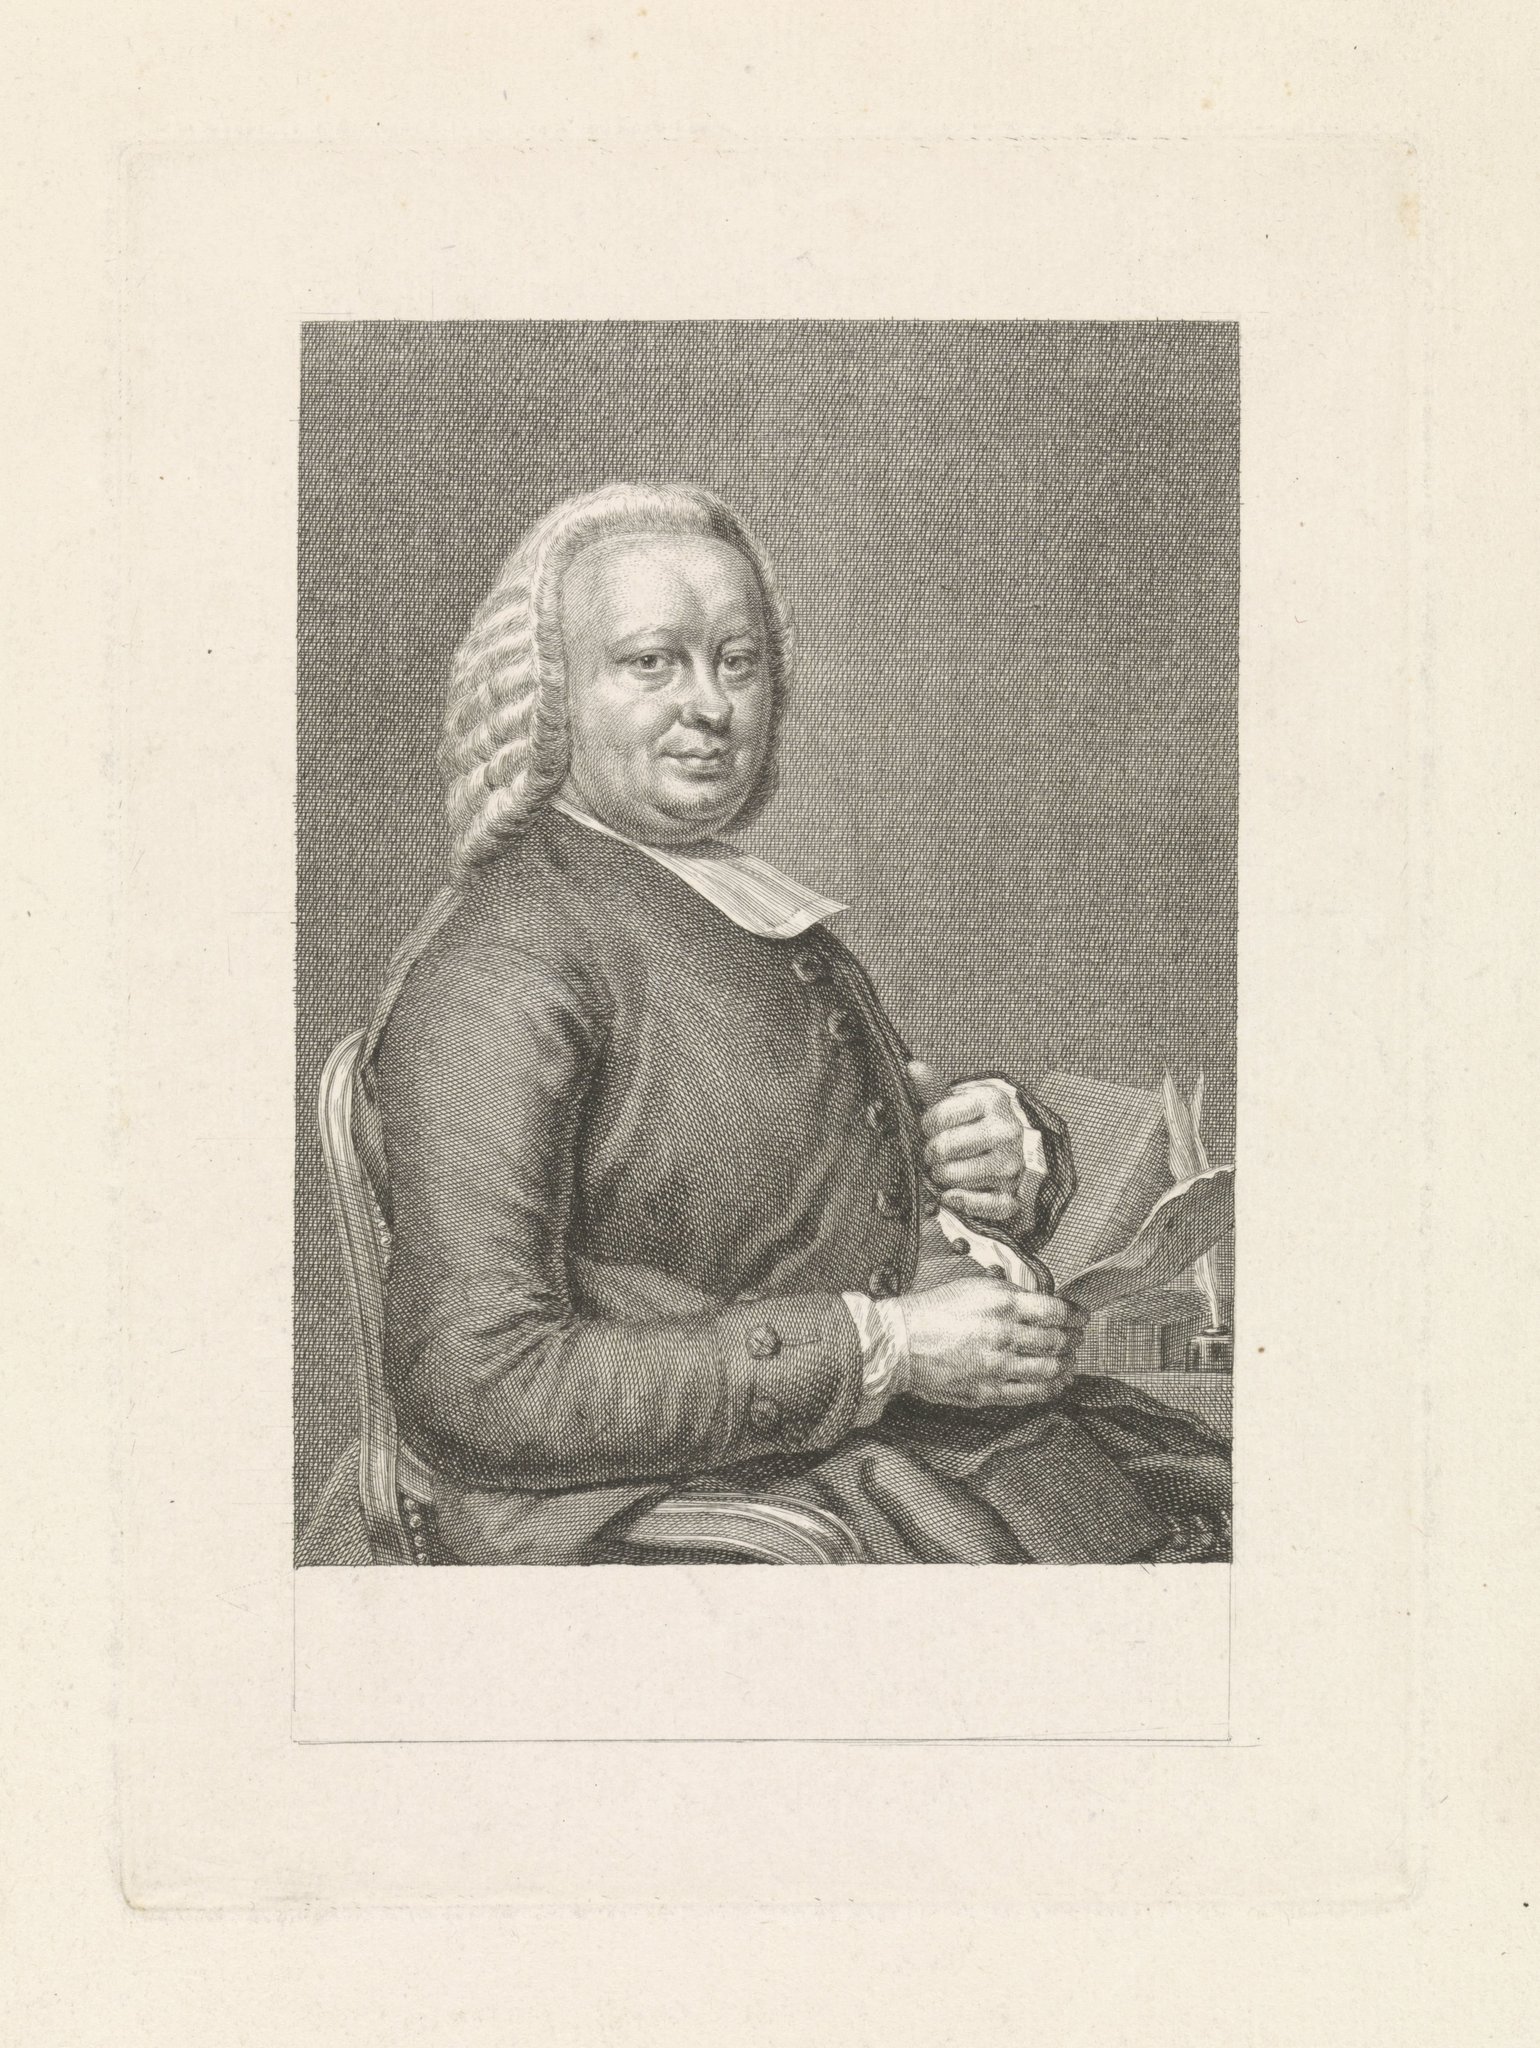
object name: print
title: Portret van Jacob van Nuys Klinkenberg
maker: jacob houbraken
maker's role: draughtsman, print maker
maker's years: 1698-1780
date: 1778-1780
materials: paper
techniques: engraving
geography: amsterdam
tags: predikant, hoogleraar, jacob van nuys klinkenberg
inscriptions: collector's mark: Lugt 2228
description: Portret ten halven lijve naar rechts van Jacob van Nuys Klinkenberg, zittend in een stoel, met in zijn hand een vel papier.